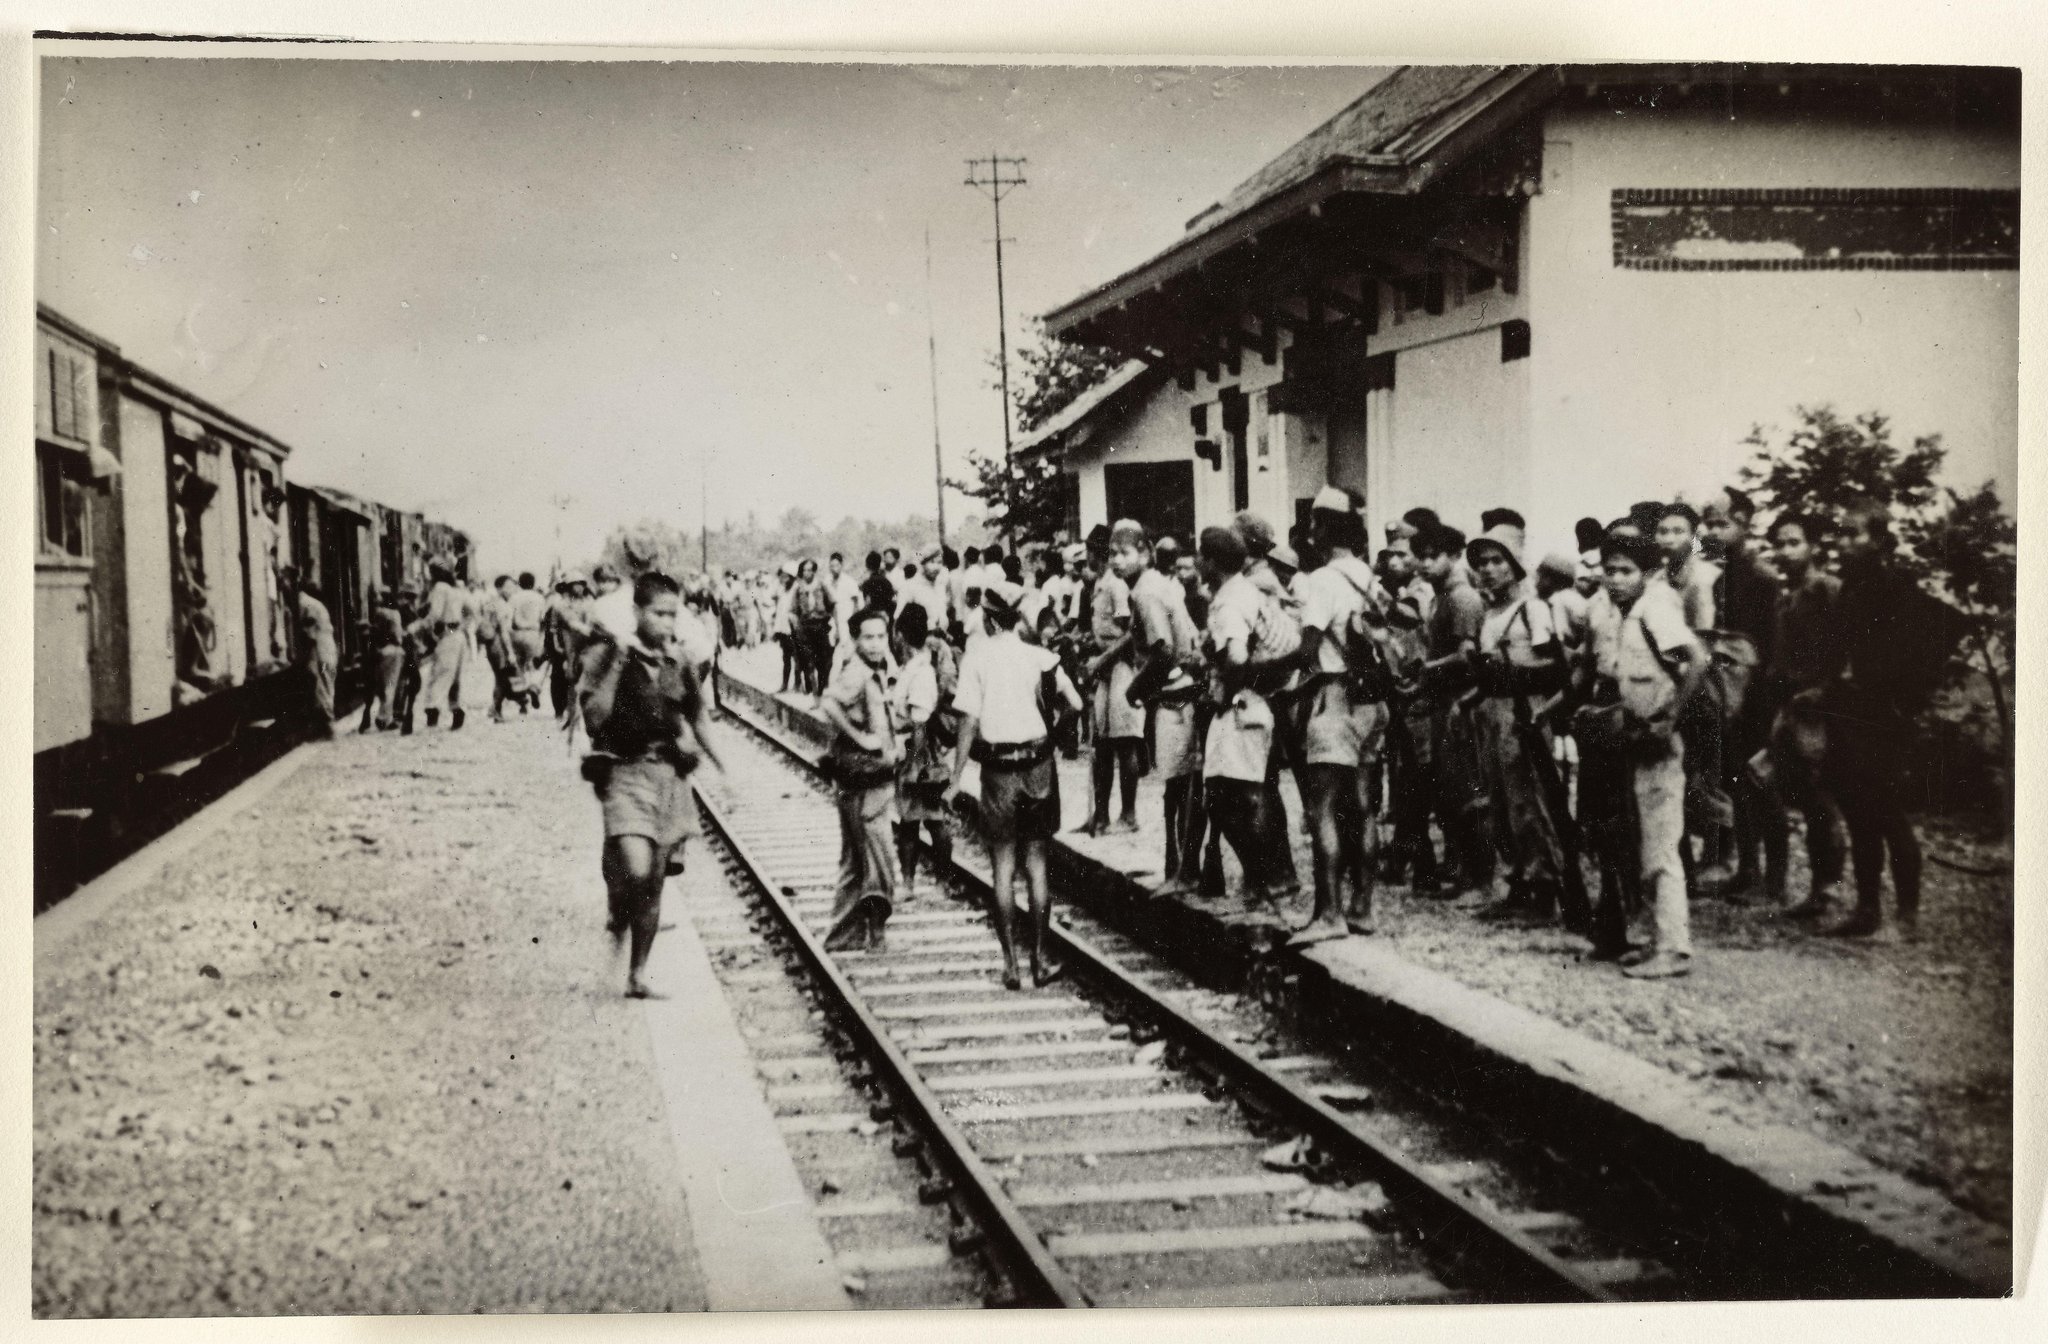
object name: documentary photograph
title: Gekaapte trein loopt het station van Tandjungrasa binnen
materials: photographic support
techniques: photography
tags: indonesia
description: Republikeinse soldaten gegroepeerd rondom het spoor kijken naar het spoor aan de overzijde waar net een gekaapte trein is binnengelopen. Op de achtergrond het station van Tandjungrasa.